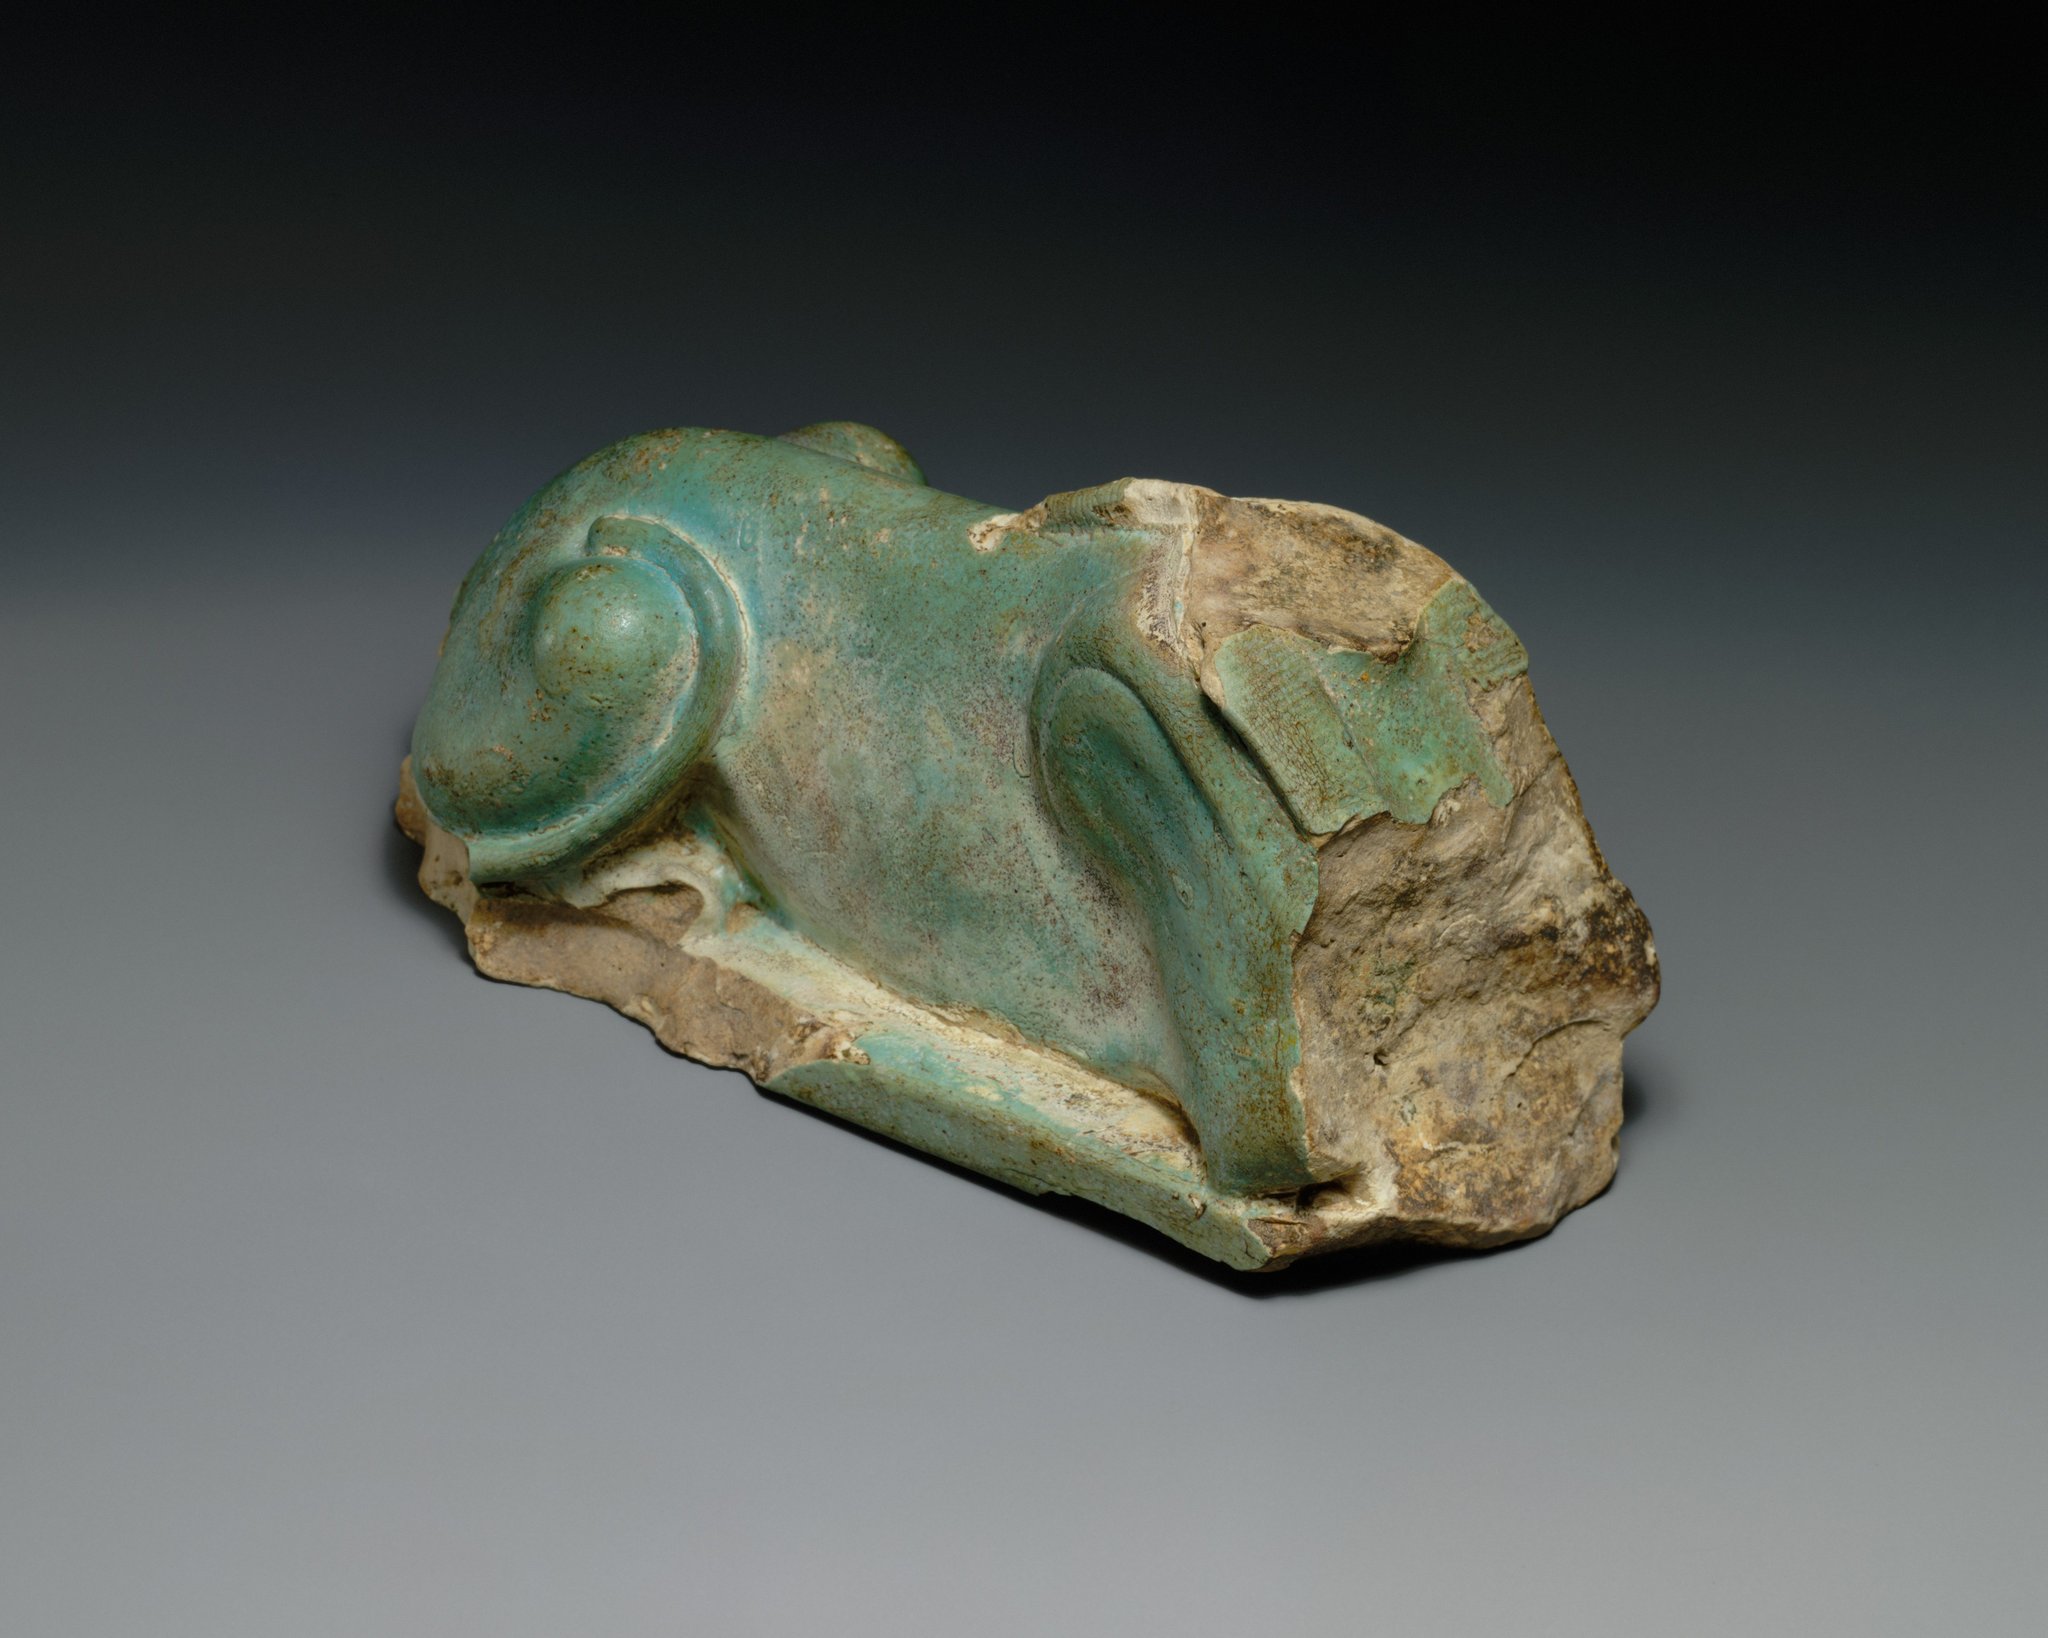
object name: sphinx body fragment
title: Body of a sphinx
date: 664-525 BCE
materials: faience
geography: egypt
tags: sphinx